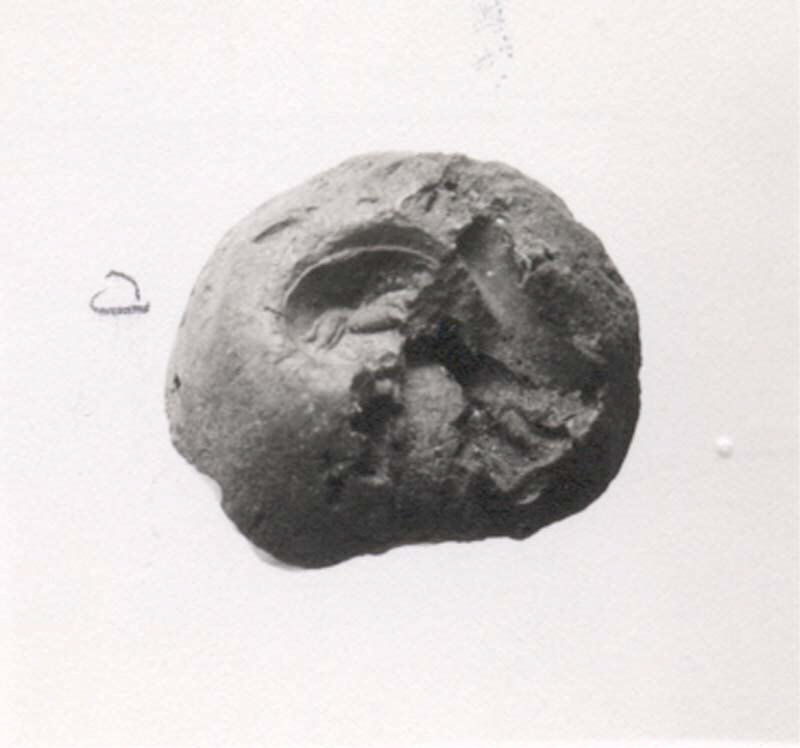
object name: sealing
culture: sasanian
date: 601-700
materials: clay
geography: iran